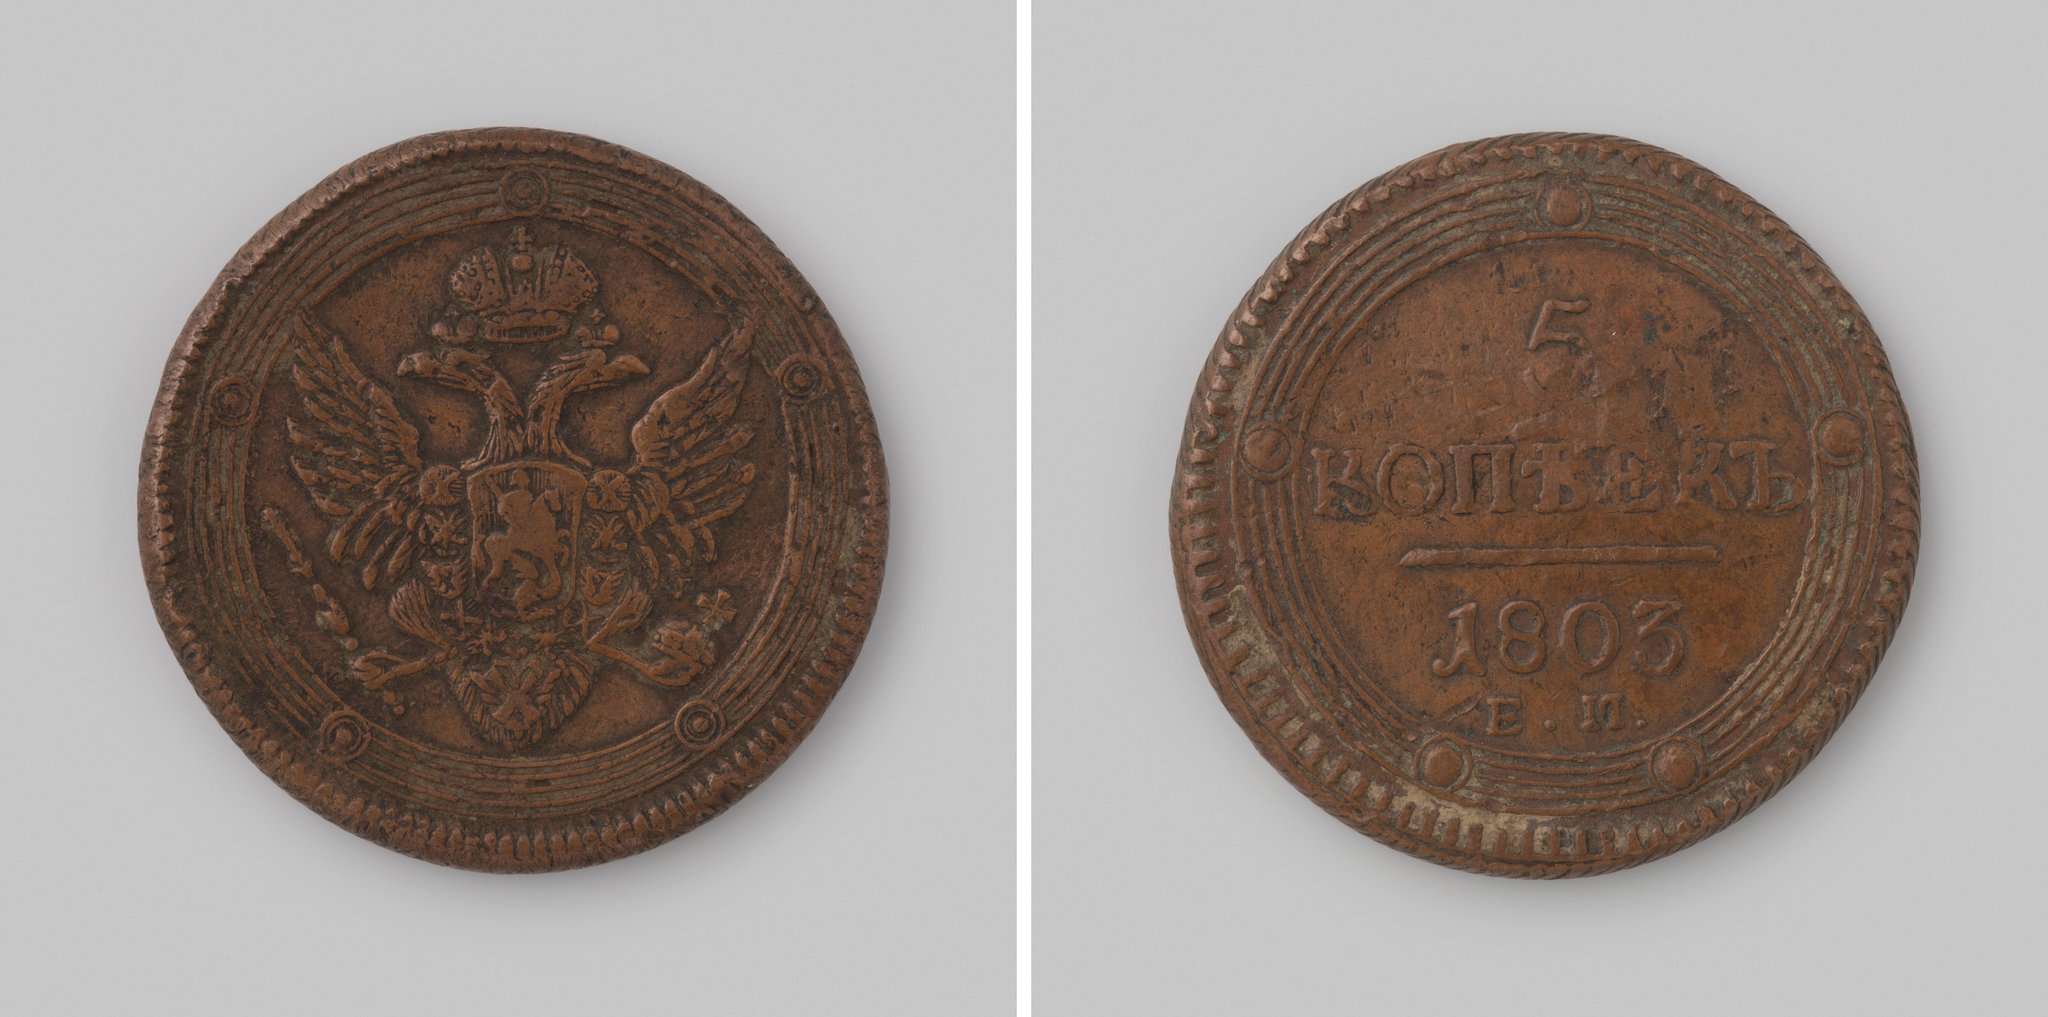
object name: coin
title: 5 kopeken uit Rusland van tsaar Alexander I, 1803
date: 1803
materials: copper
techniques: striking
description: Koperen munt. Voorzijde: dubbelkoppige gekroonde adelaar met gespreide vleugels, met op zijn borst door ridderorde omhangen wapenschild en met in zijn poten scepter en bol met daarop kruis. Boven de adelaar een kroon. Rondom de adelaar op een aantal cirkels 5 stippen als waarde-aanduiding. Keerzijde: binnen een op een aantal cirkels, waarop 5 stippen als waarde-aanduiding. waarde-aanduiding in twee regels, waaronder jaartal. Daronder de letters E M [=Ekaterinenburg]. Kabelrand.